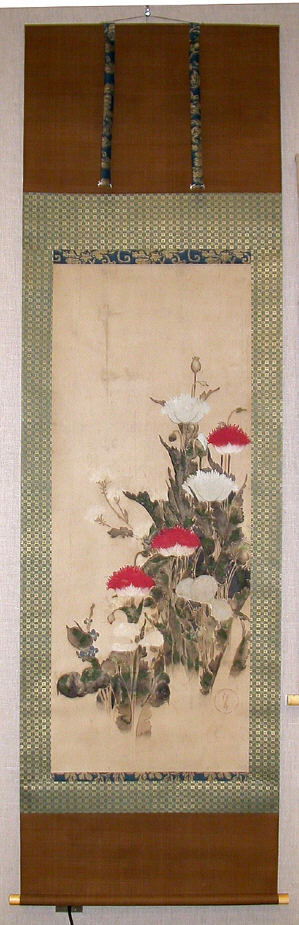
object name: hanging scroll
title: Red and White Poppies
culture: japanese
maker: tawaraya sōtatsu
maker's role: artist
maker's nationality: japanese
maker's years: 1570-1640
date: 1601-1700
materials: ink, paper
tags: poppies